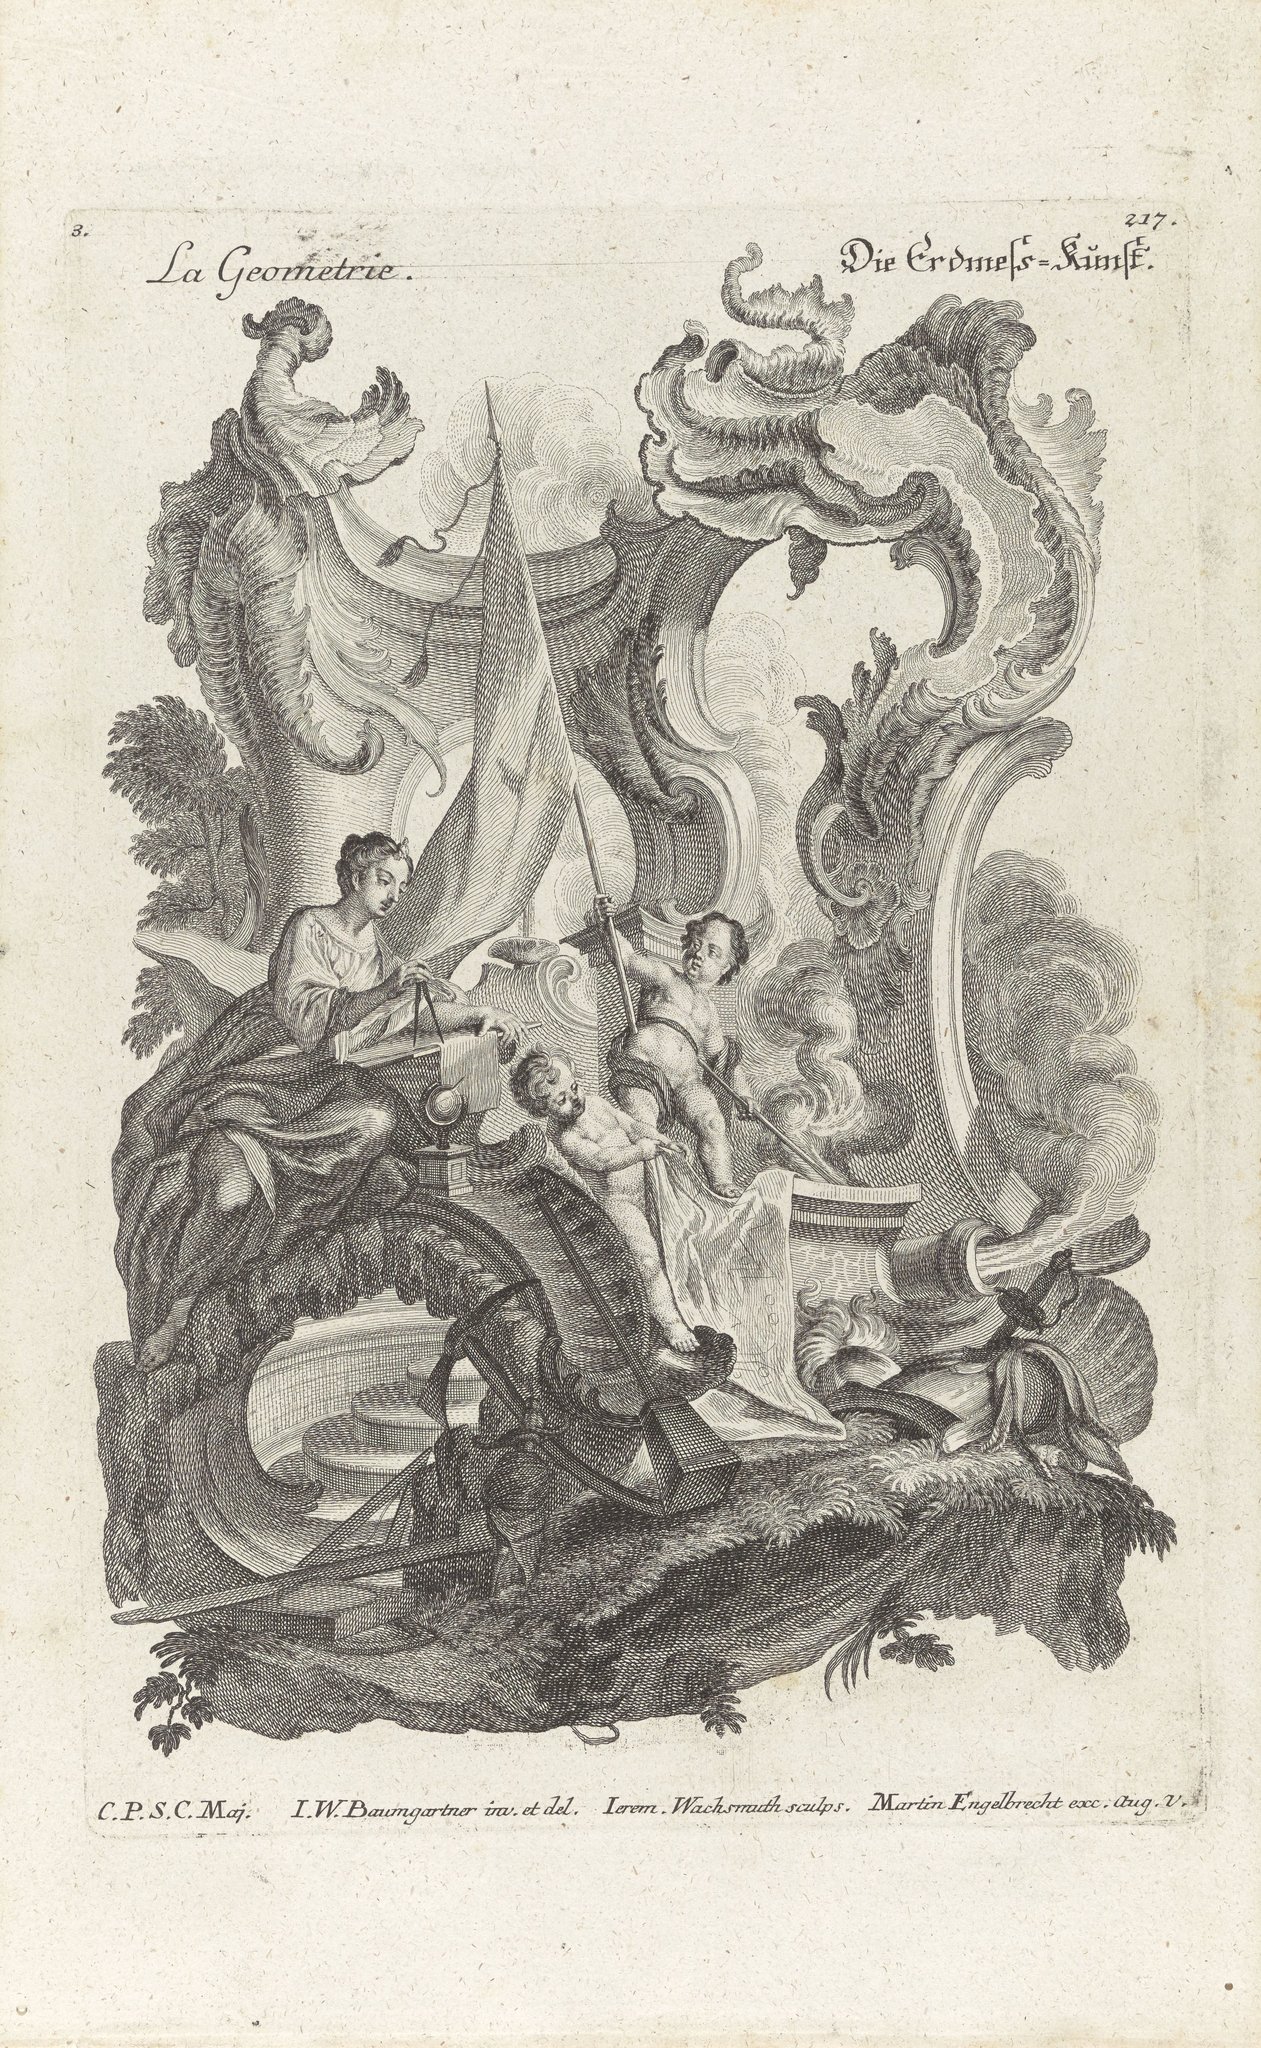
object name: print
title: De zeven vrije kunsten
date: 1719-1749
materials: paper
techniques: engraving, etching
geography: augsburg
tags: tools, aids, implements ~ crafts and industries, rocaille ornament, 'geometria' (~ quadrivium); 'geometria' (ripa)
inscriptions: collector's mark: Lugt 2228, collector's mark: Lugt 2760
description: Links zit de Meetkunde of Geometrie met een passer. Voor haar twee putti met een vaandel en een tekening met geometrische motieven. Op de grond ligt gereedschap. Rechtsboven 217 genummerd.